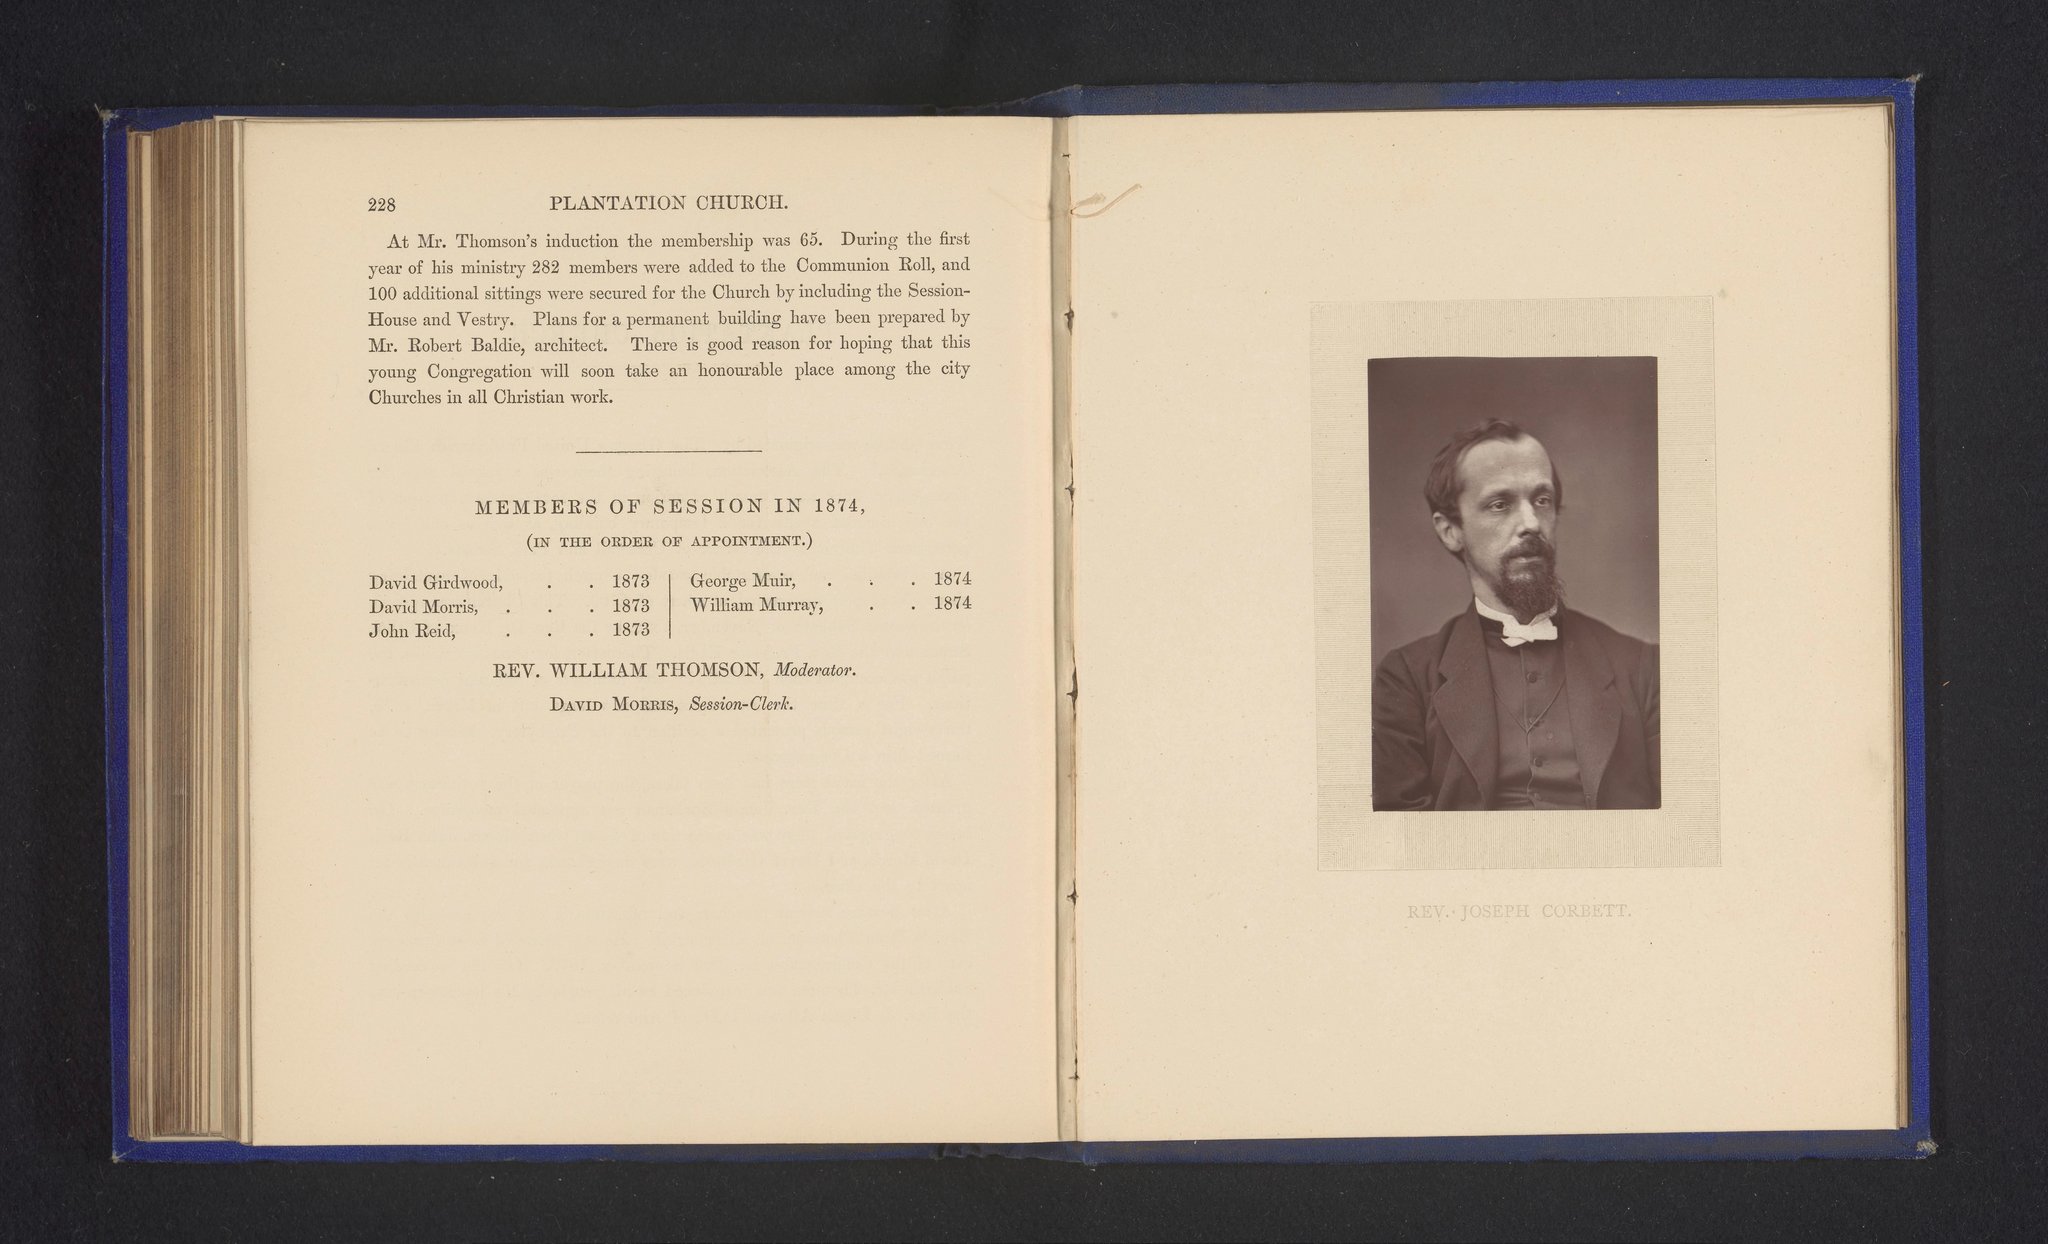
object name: page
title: Rev. Joseph Corbett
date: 1874-1875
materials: paper, photographic support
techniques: carbon print, woodburytype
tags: functionaries and dignitaries (with name) ~ protestant churches